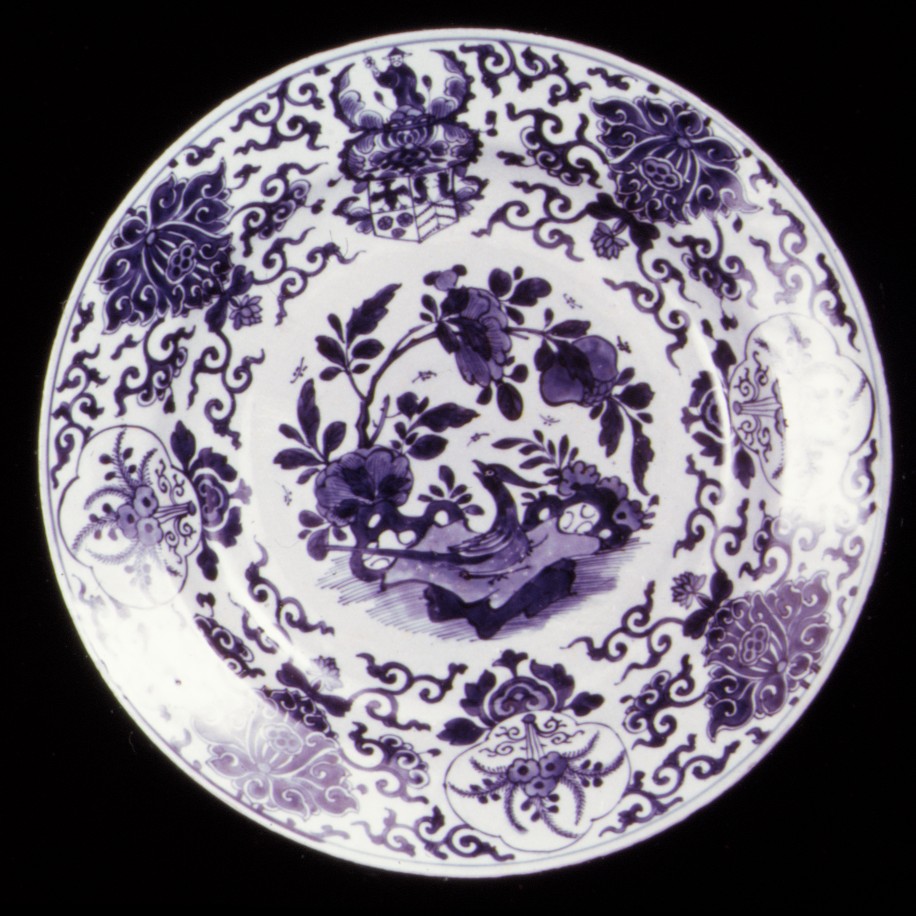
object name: dish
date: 1705-1713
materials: porcelain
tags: birds,flowers,insignia